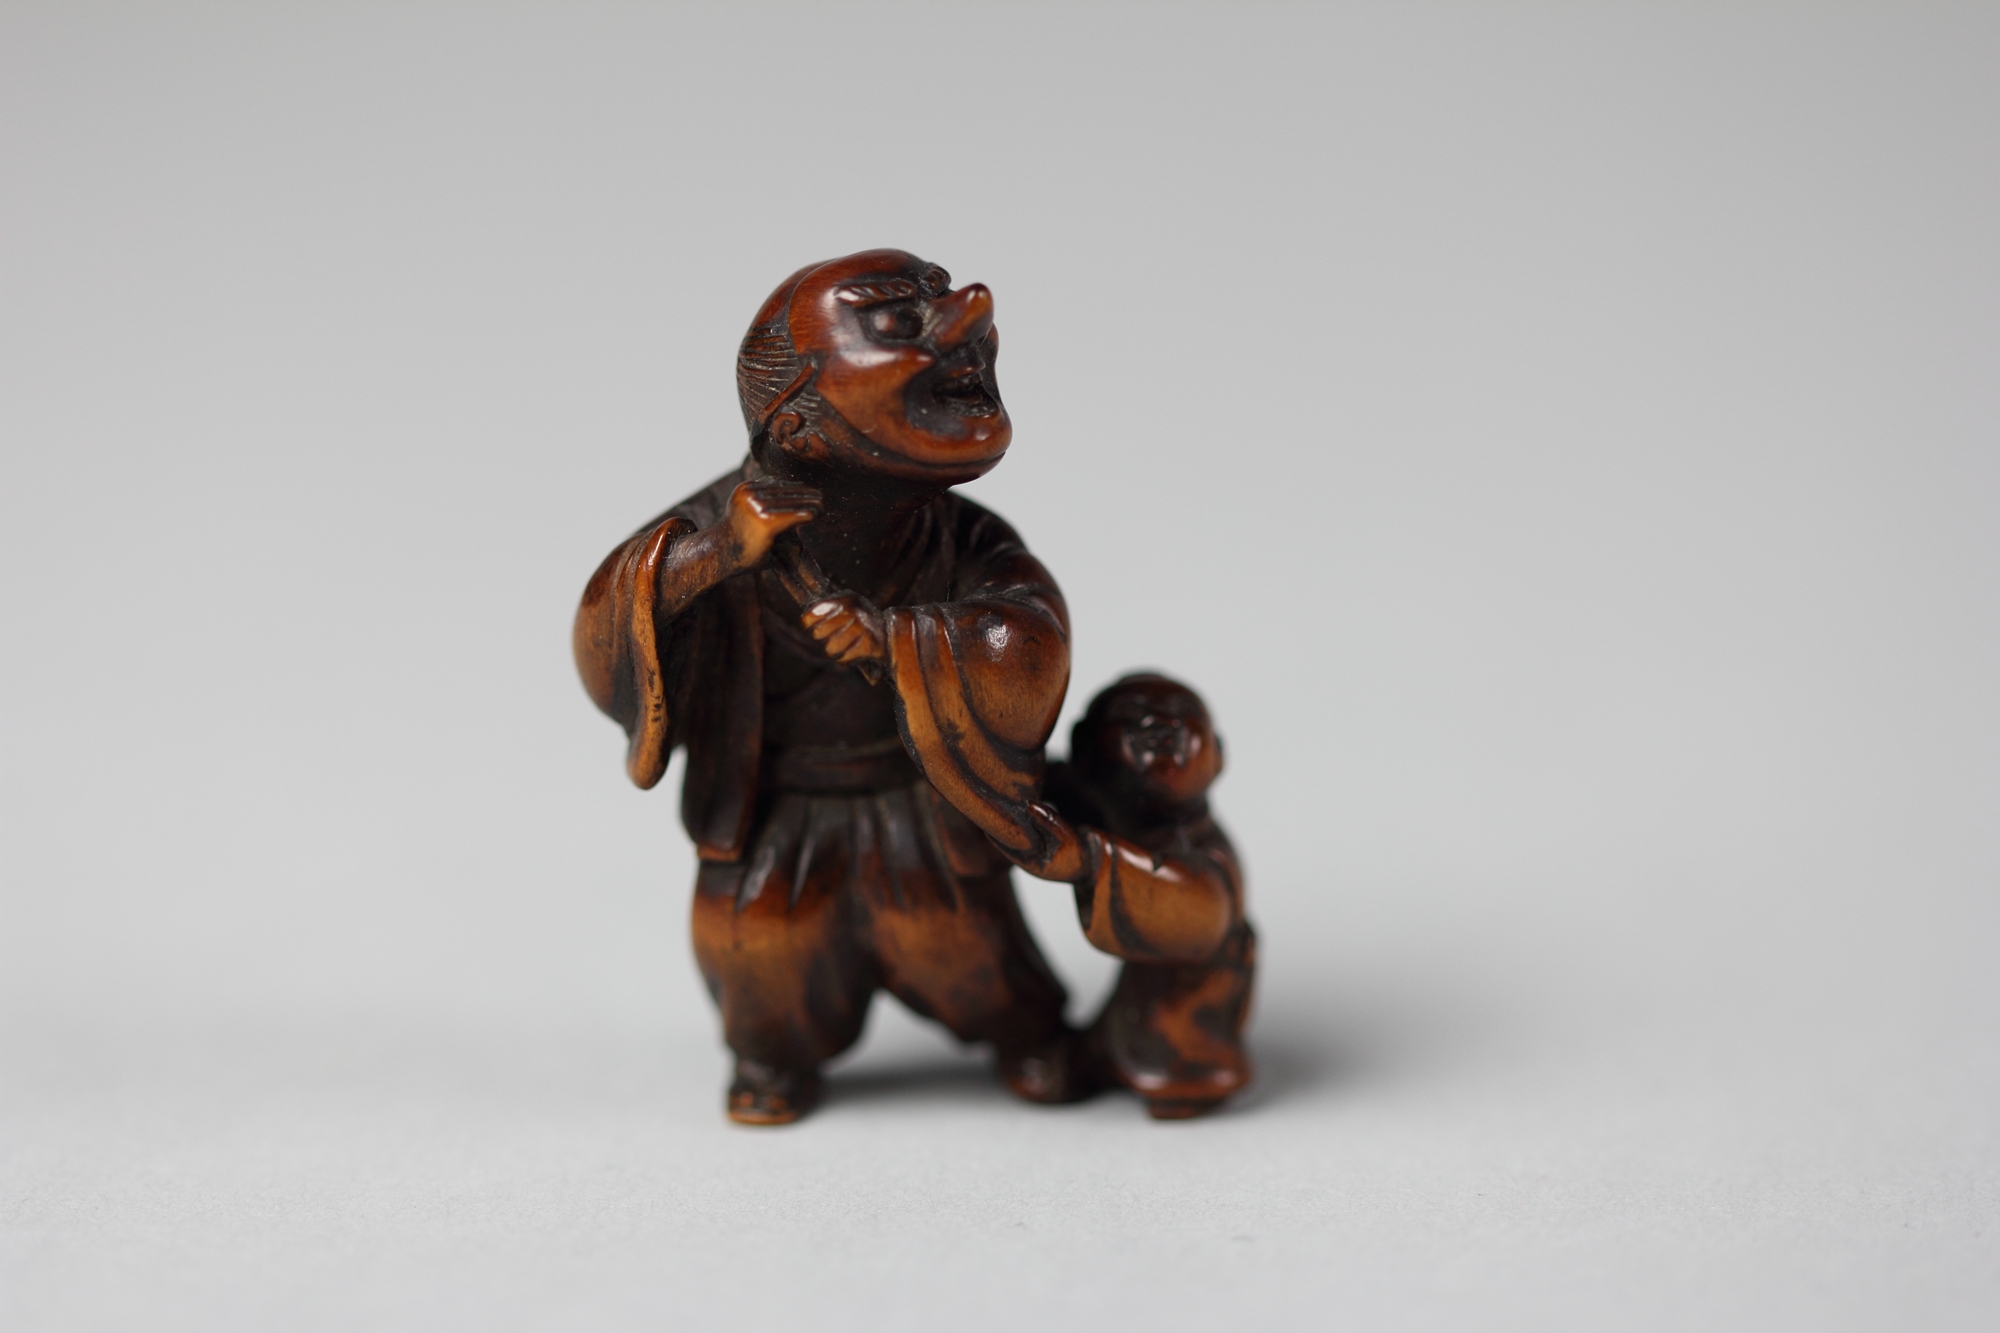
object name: netsuke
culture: japanese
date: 1701-1800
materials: wood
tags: children,men